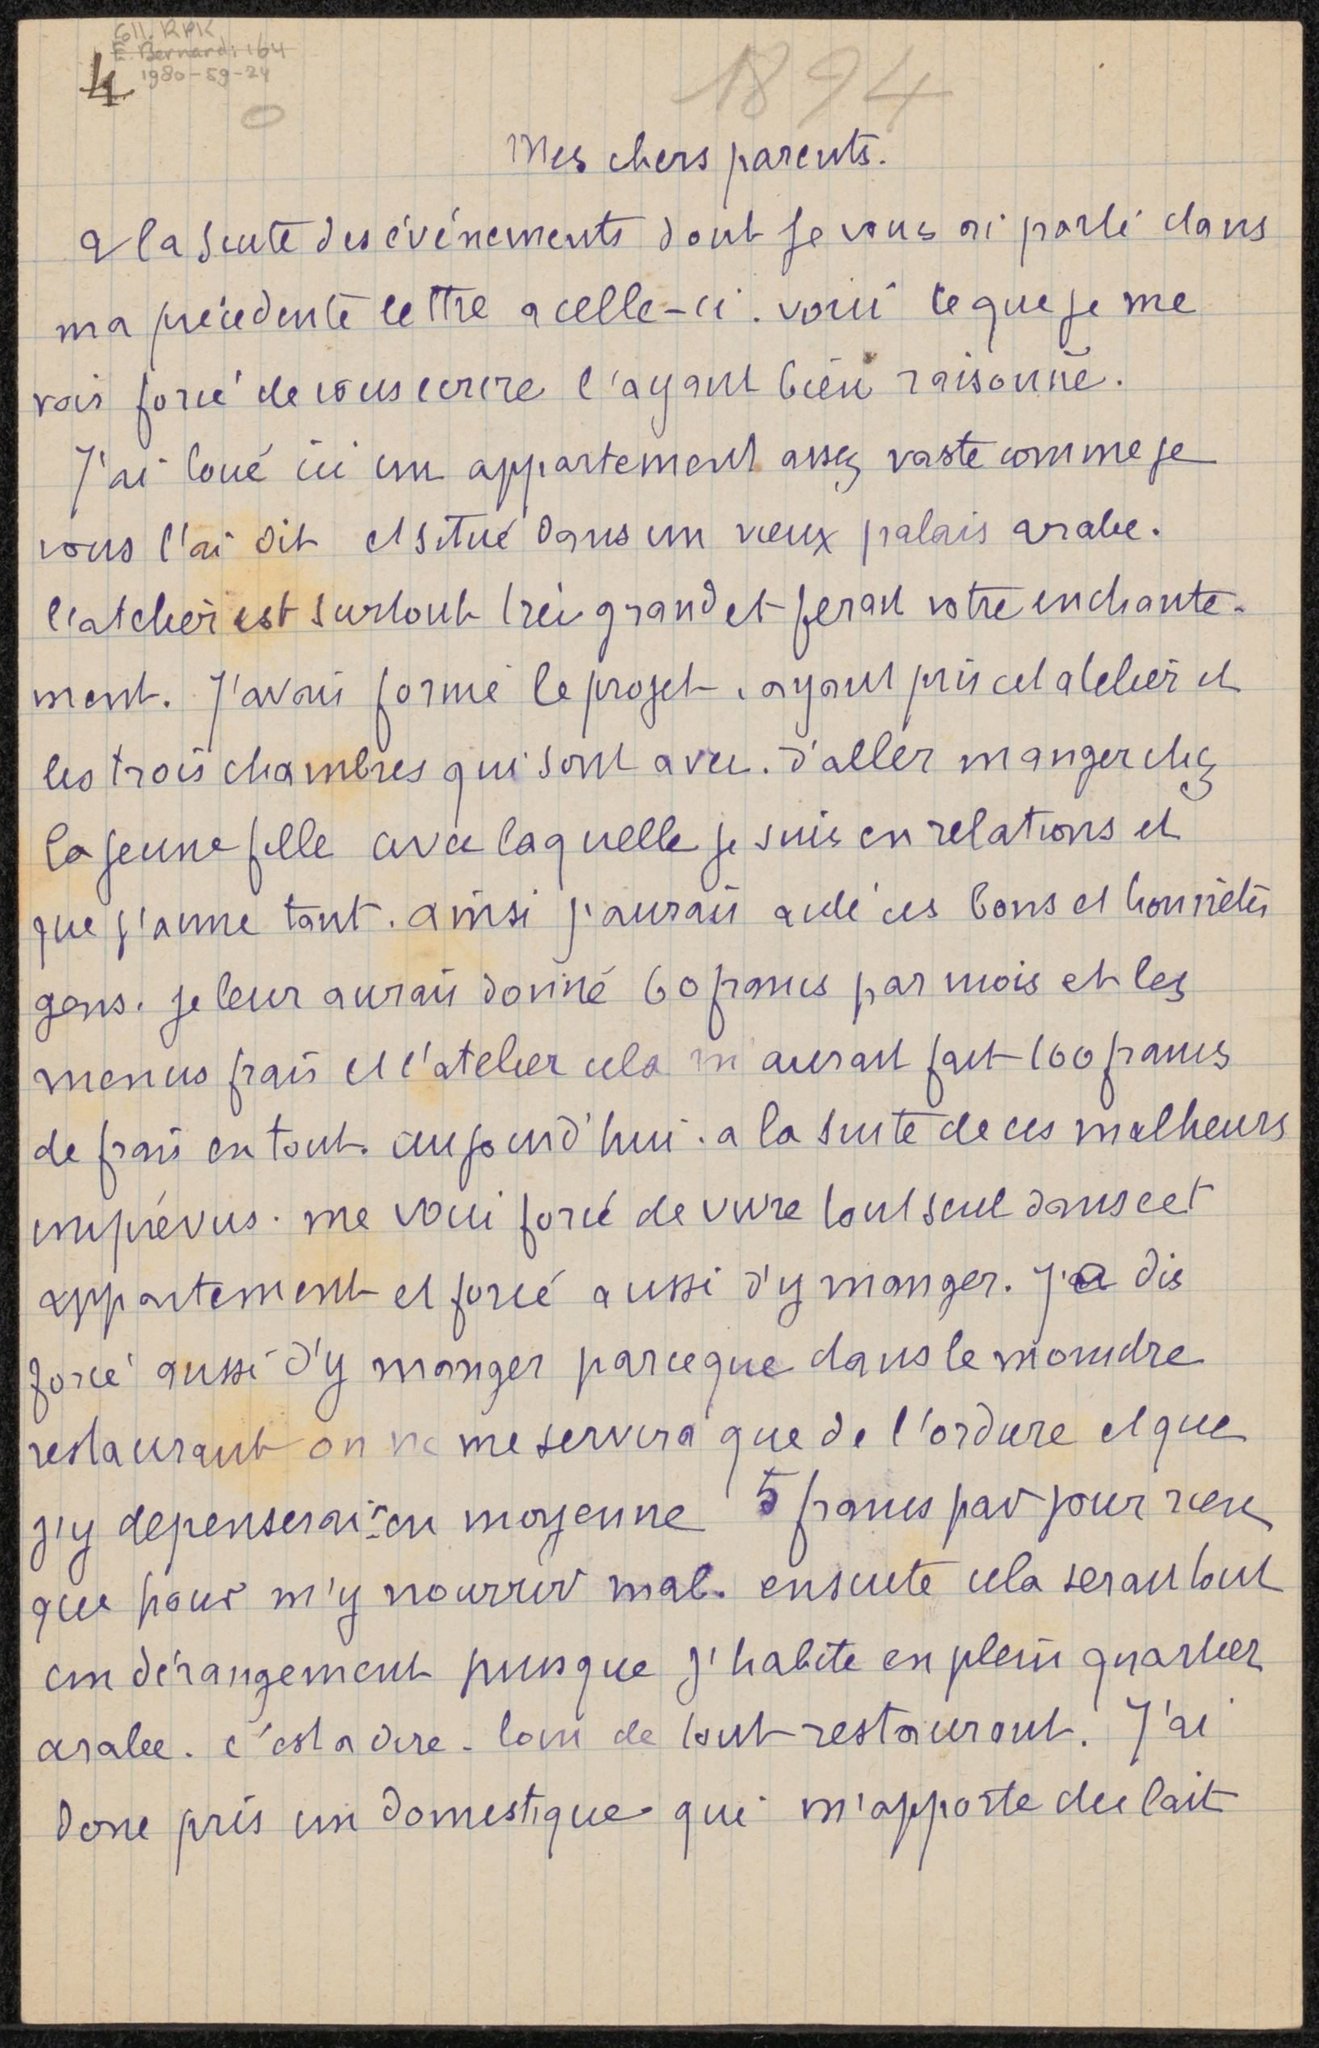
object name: letter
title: Brief aan Emile Ernest Bernard en Héloïse Bernard-Bodin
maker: émile bernard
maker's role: print maker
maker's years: 1868-1941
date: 1878-1941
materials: ink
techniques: pen, writing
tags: héloïse bernard-bodin, emile ernest bernard